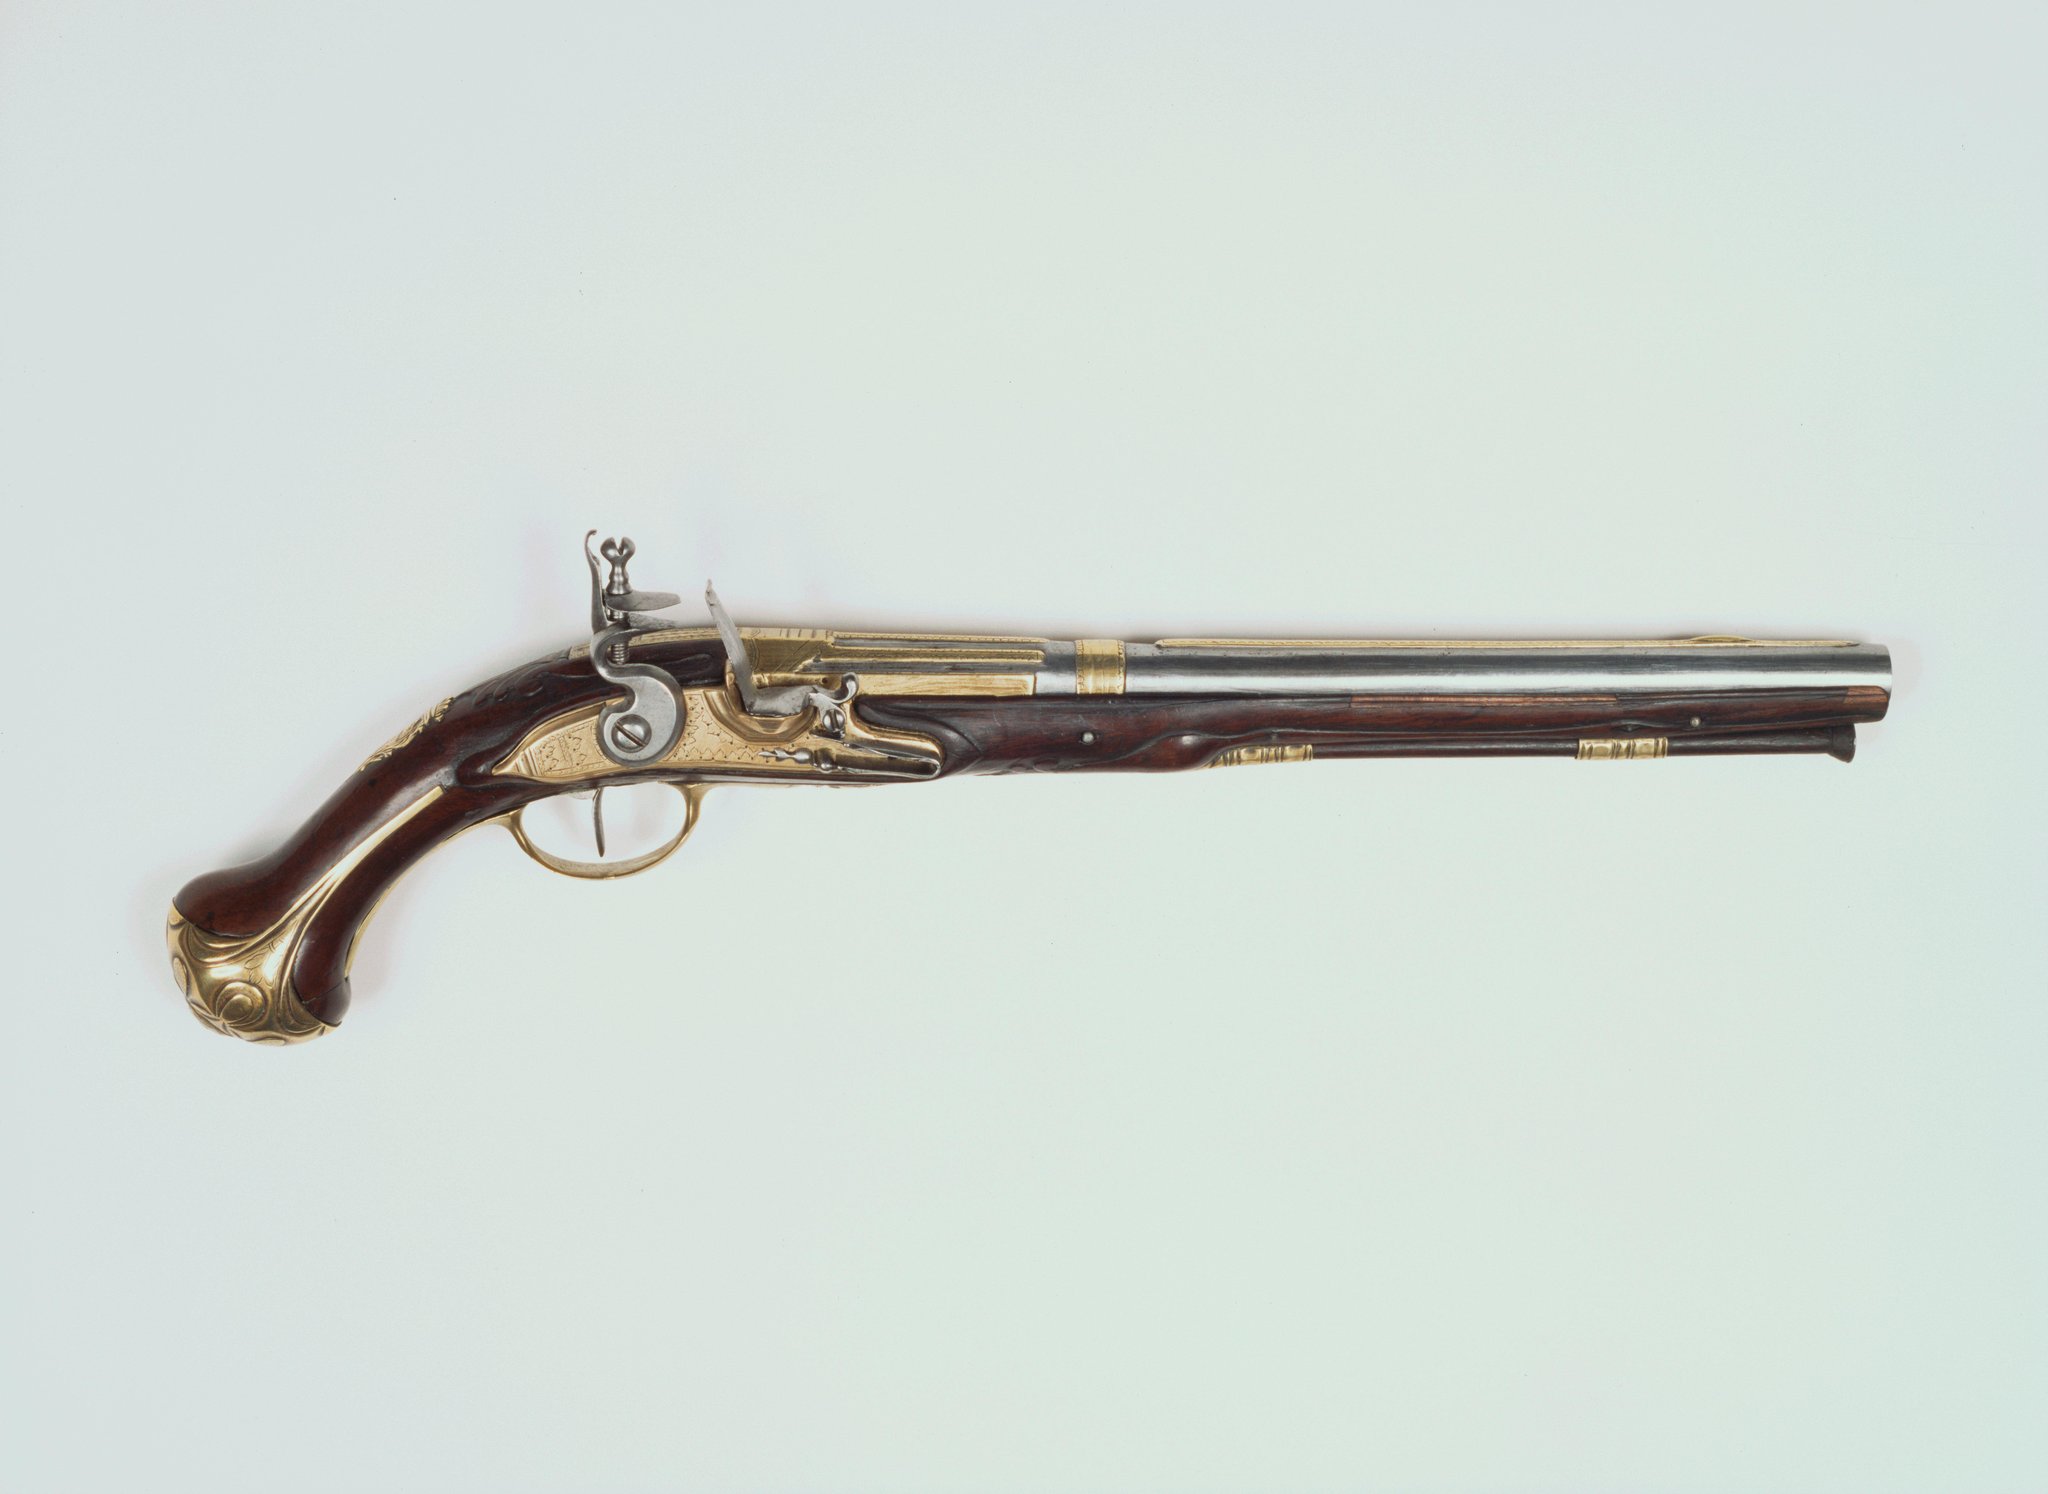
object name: pistol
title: Vuursteenpistool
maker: Anonymous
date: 1700-1800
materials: brass, bronze, copper, iron, wood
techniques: engraving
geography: western europe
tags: netherlands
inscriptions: : ‘A. Croissant’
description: Vuursteenpistool met ijzeren gladde ronde loop die door een messing profielband wordt onderbroken, aan het uiteinde van de loop een lage rondvormige messing vizierkorrel, over de lengte van de loop een beslag van messing, op de kulas geribbelde messing motieven. Messing slotplaat met ijzeren haan, ijzeren vuurstaal en ijzeren staalveer, de pan is van messing. Op de slotplaat diverse ingegraveerde motieven, aan de onderkant van de slotplaat de naam "A. CROISSANT". Lade is van notenhout en heeft aan de onderzijde bladmotief. De kolf is eveneens van notenhout met een kolfkap van messing in de vorm van diverse bladmotieven. Op de kolfhals een messing voluut waarin het hoofd van een man te zien is, in het hout boven de voluut een bladmotief. Aan de andere zijde van de lade een beslag van messing welke zo is gemaakt dat er gaten in lijken te zitten. Trekkerbeugel van messing welke aan het uiteinde een bladfmotief heeft, ijzeren trekker. Onder de lade een laadstok die door twee kokers van messing wordt gedragen.